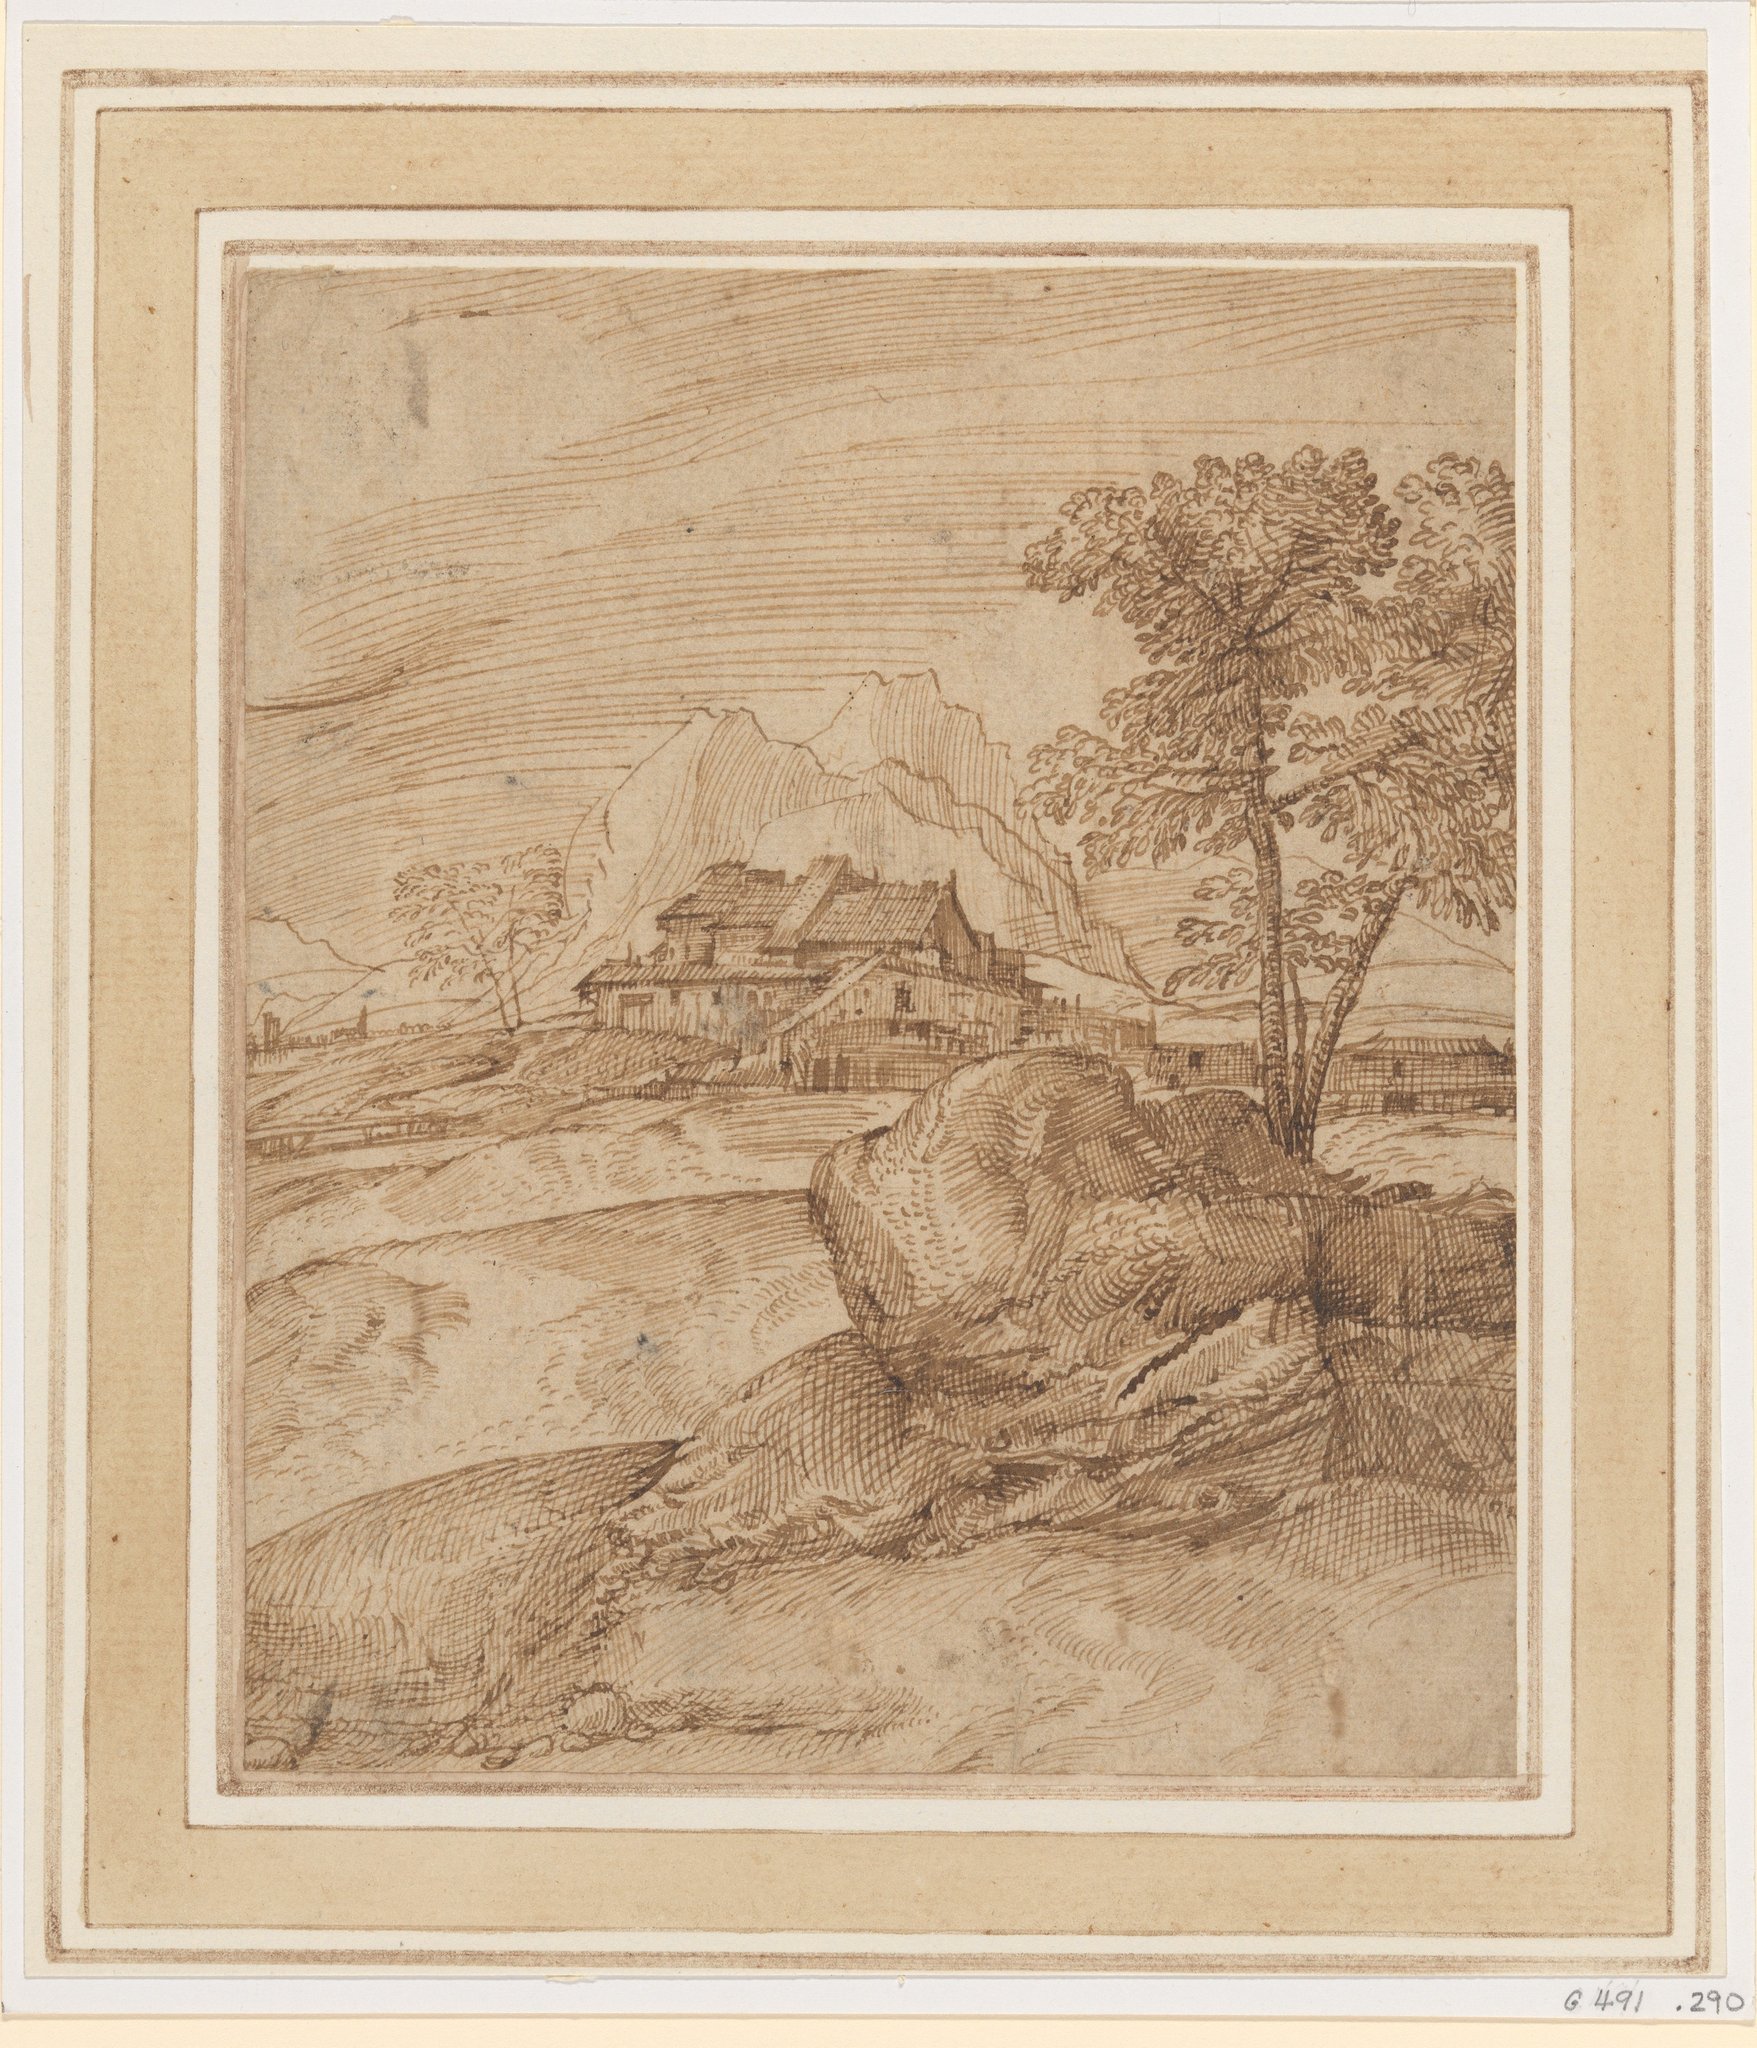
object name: drawing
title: Mountainous Landscape with a Rock, Trees, and Buildings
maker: domenico campagnola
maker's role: artist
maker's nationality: italian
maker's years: 1500-1564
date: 1520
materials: ink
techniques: pen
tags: landscapes